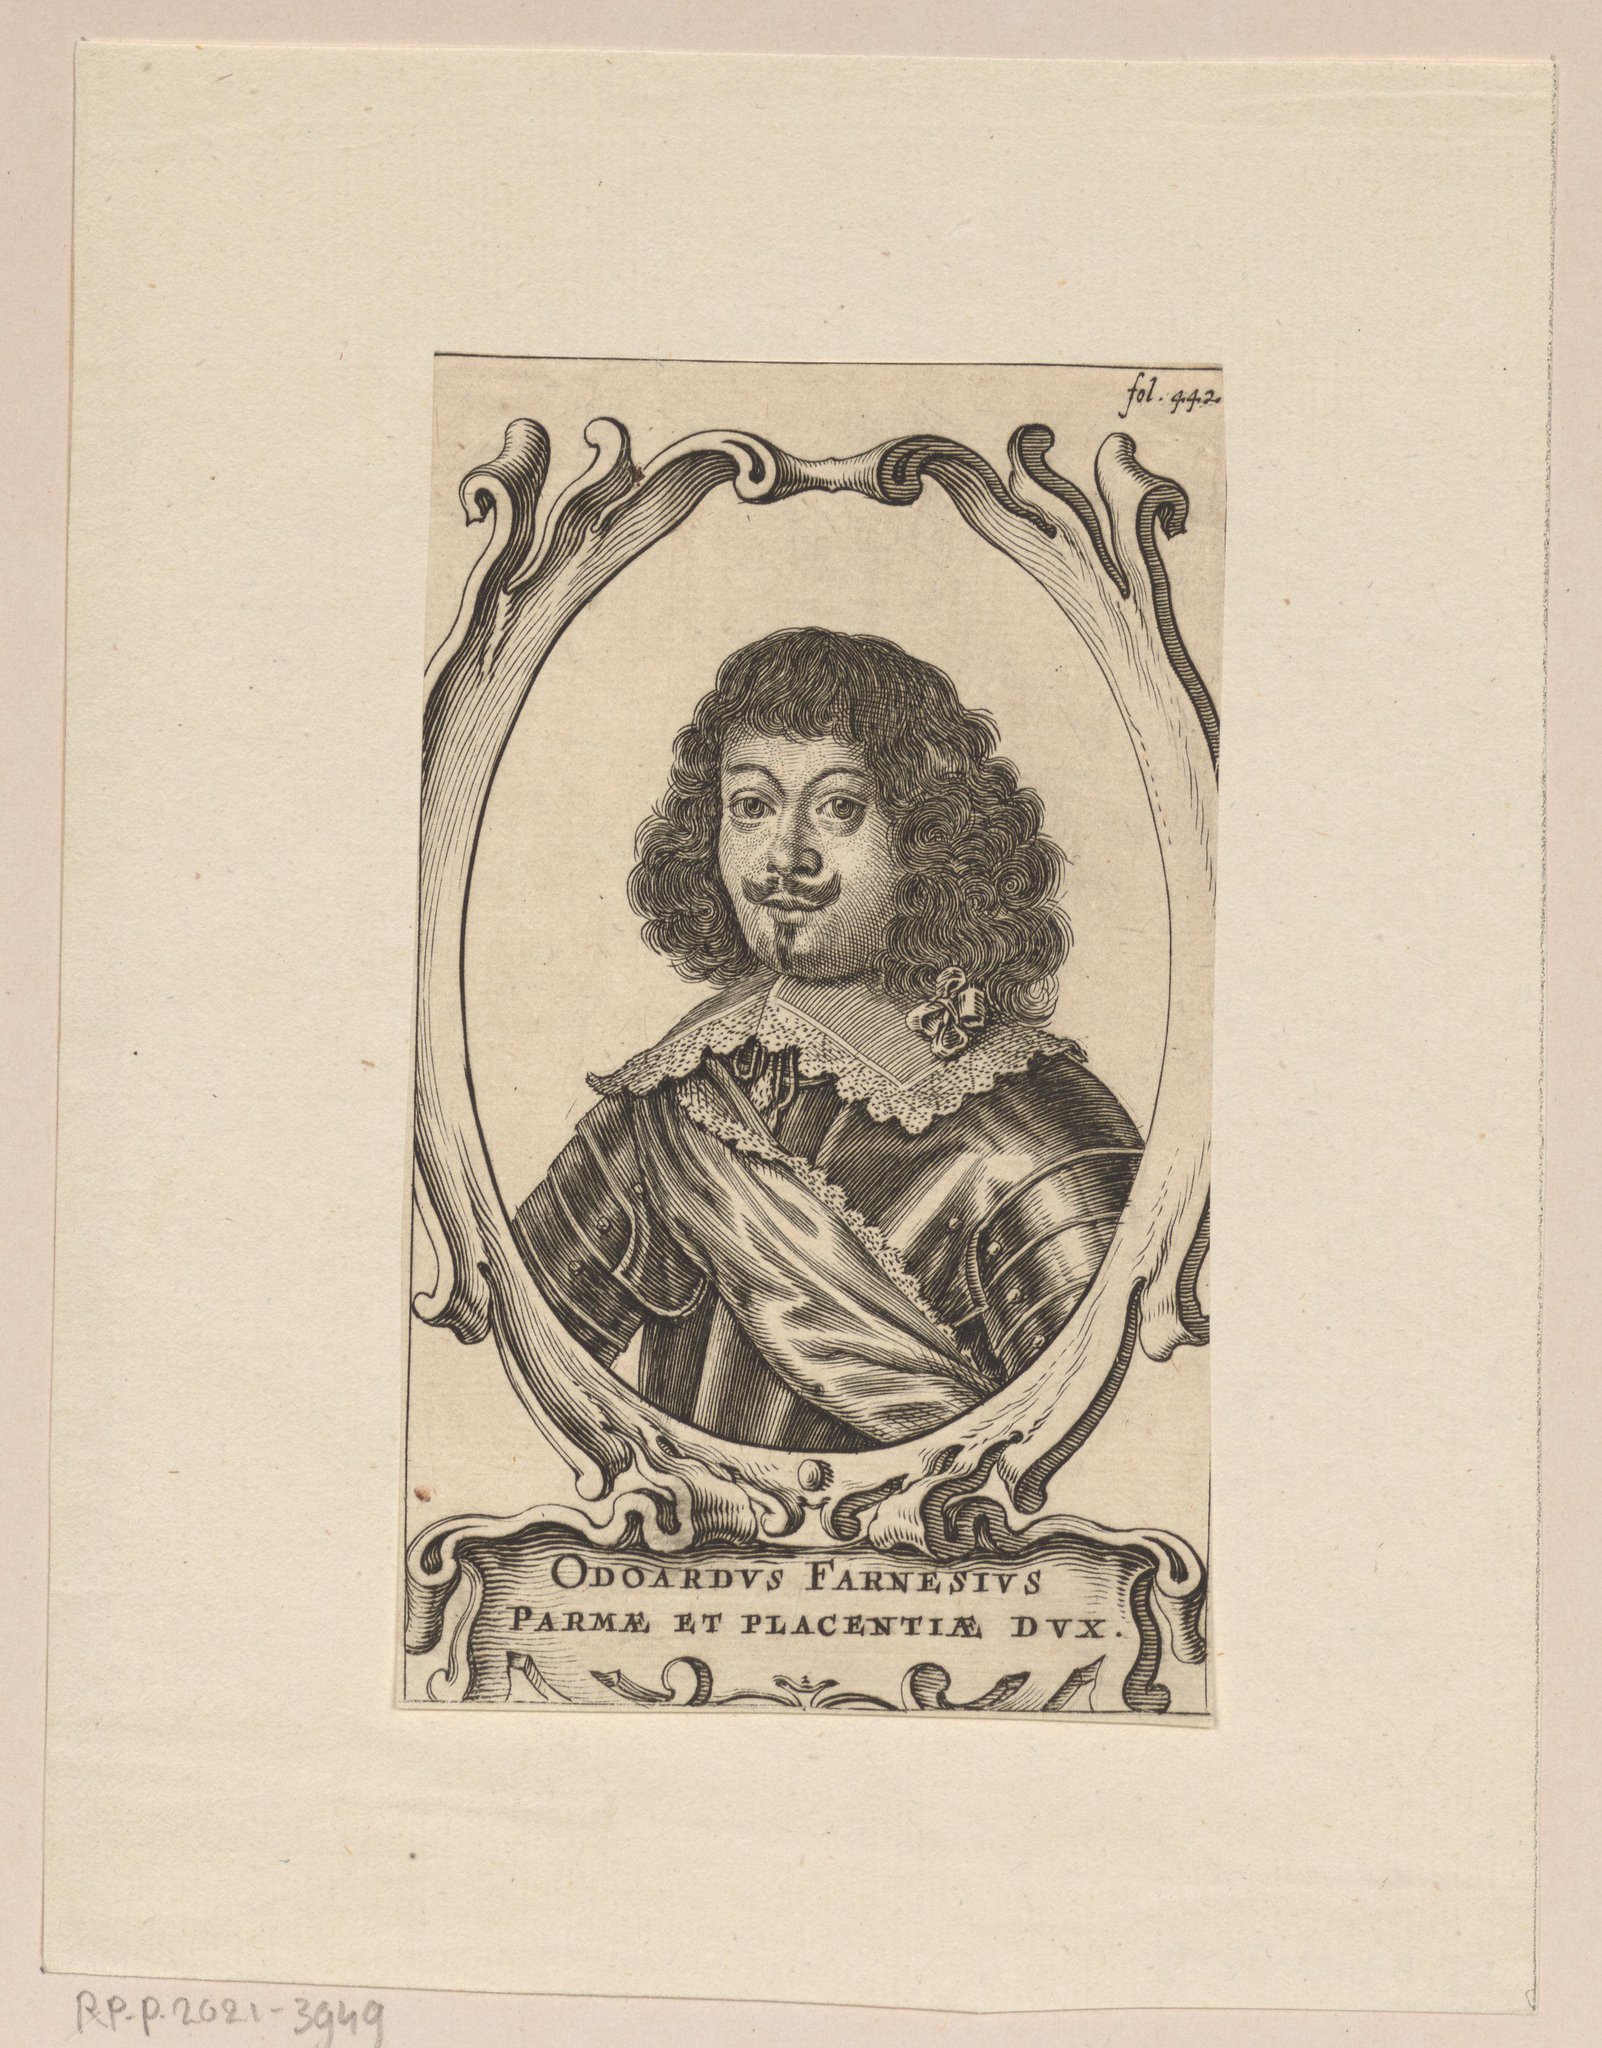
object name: print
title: Portret van Odoardo Farnese, hertog van Parma en Piacenza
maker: Anonymous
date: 1656-1666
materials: paper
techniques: engraving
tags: rocaille ornament, armour, historical persons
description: Prent mogelijk uit: Brachel, Johann Adolph. Historia nostri temporis, dat is: Geschiedenis onses tijdts (...). Rotterdam: Andries van Hoogenhuyse, 1656, dl. 1. Of uit een latere editie (1659, 1666).